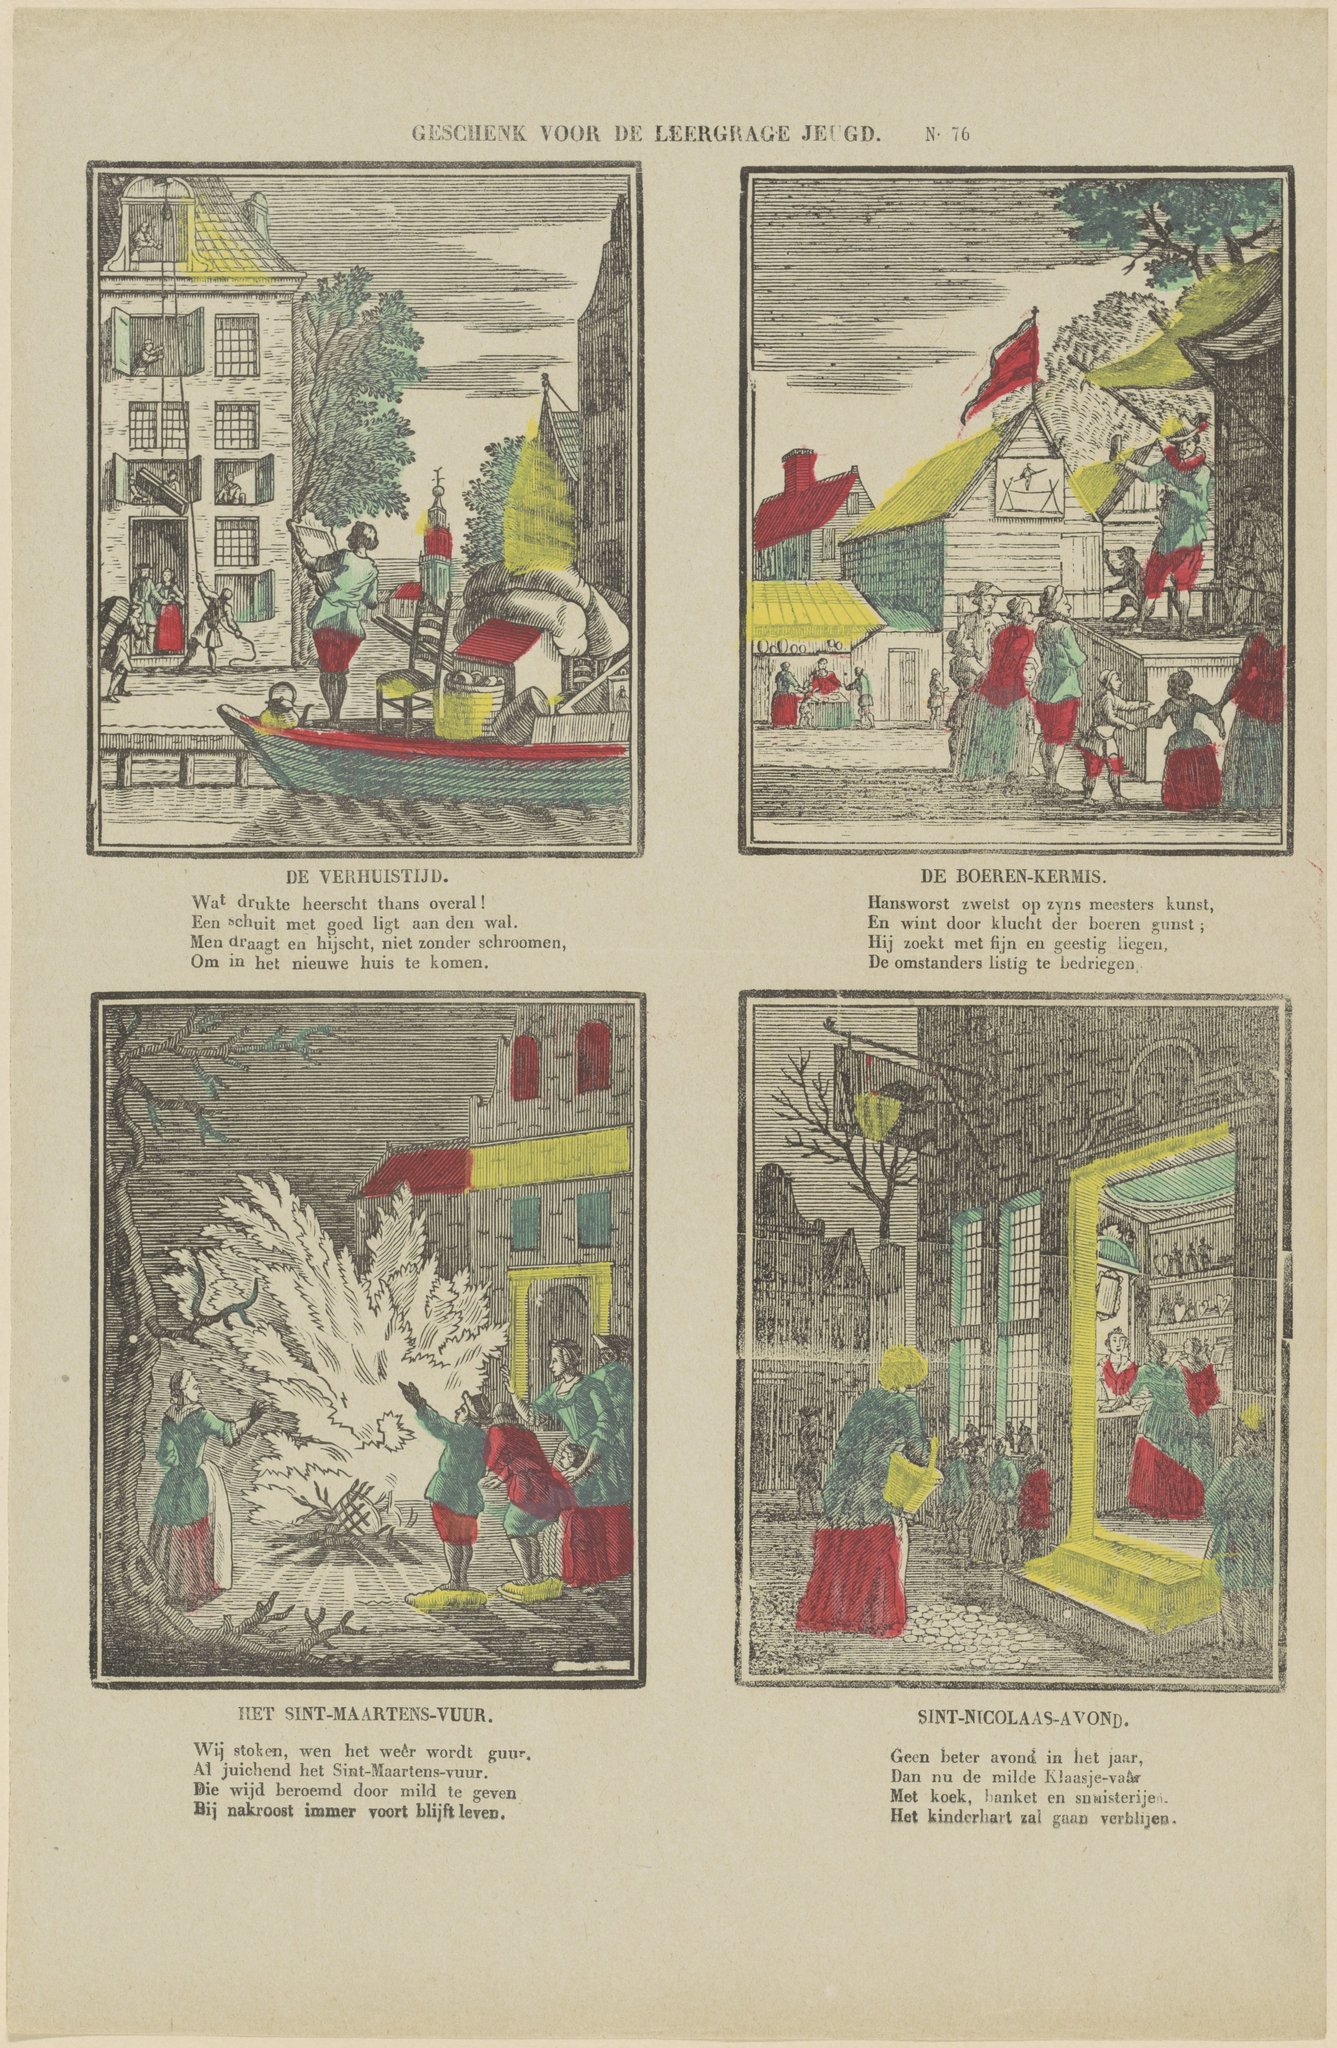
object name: print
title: Geschenk voor de leergrage jeugd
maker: franciscus antonius beersmans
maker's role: publisher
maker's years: 1840-1897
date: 1866-1902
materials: paper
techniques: colour, letterpress printing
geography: turnhout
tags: moving (house), st. martin's day (november 11), festivities on st. nicholas (eve) (december 5), pleasure fair and circus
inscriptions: collector's mark: Lugt 2760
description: Blad met 4 voorstellingen van de verhuistijd, de boerenkermis, het Sint Maartensvuur en Sinterklaasavond. Onder elke afbeelding een titel en een vierregelig vers. Genummerd rechtsboven: N. 76.